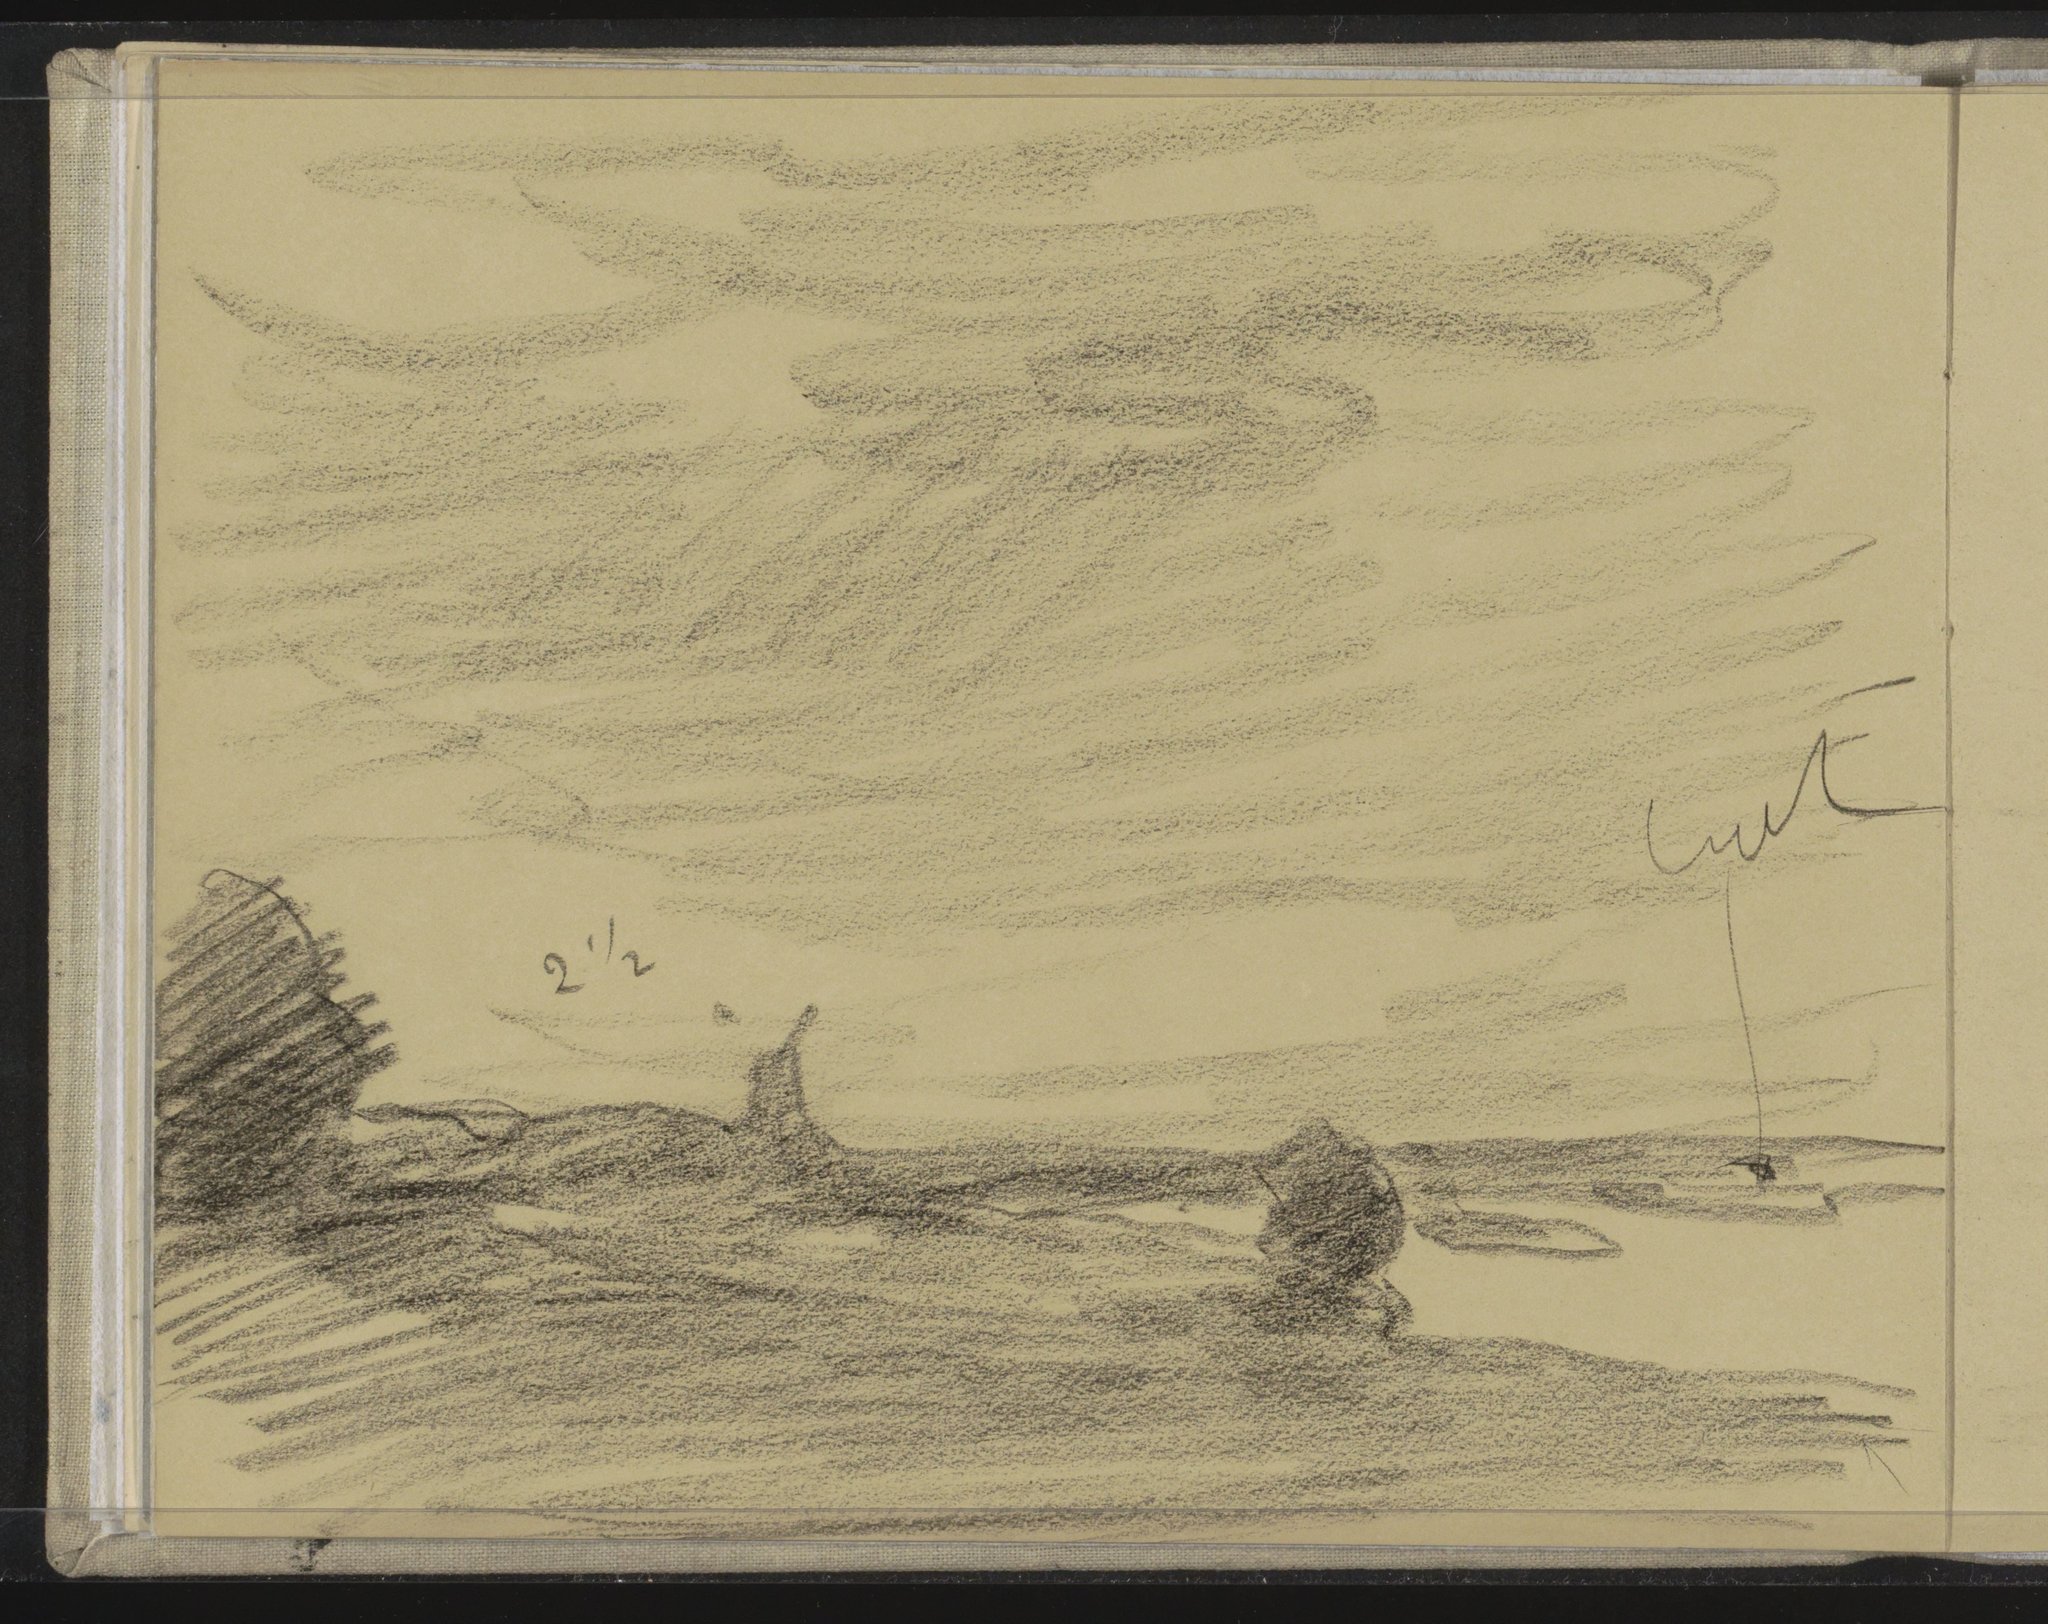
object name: sketchbook leaf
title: Rivierlandschap met een molen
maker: willem witsen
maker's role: draughtsman, painter, print maker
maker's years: 1860-1923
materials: chalk, paper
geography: wijk bij duurstede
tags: river, windmill in landscape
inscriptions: annotation: ‘2 1/2’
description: Pagina 48 uit een schetsboek met 43 bladen.